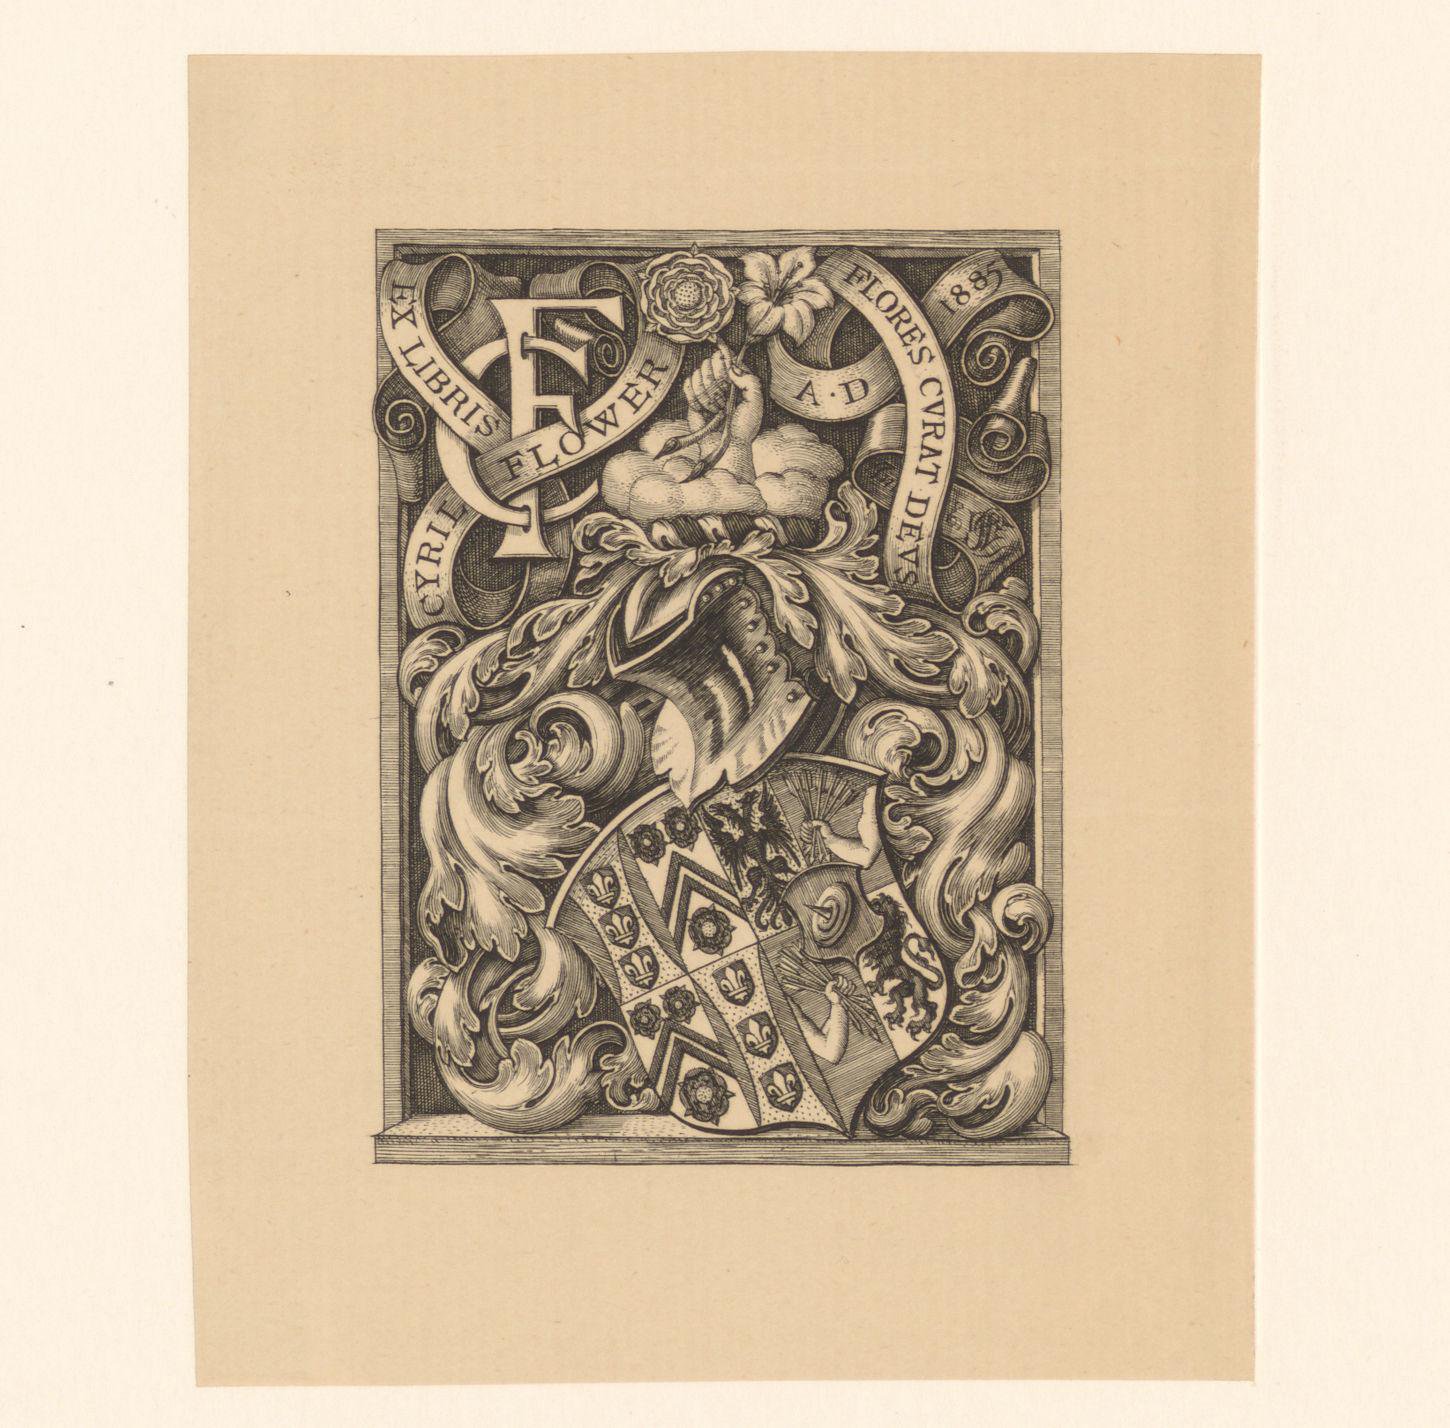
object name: bookplate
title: Ex libris van Cyril Flower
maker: charles william sherborn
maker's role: print maker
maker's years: 1831-1912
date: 1841-1912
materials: paper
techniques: engraving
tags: politician, flowers, foliage ~ ornament, armorial bearing, heraldry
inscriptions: collector's mark: Lugt 2228